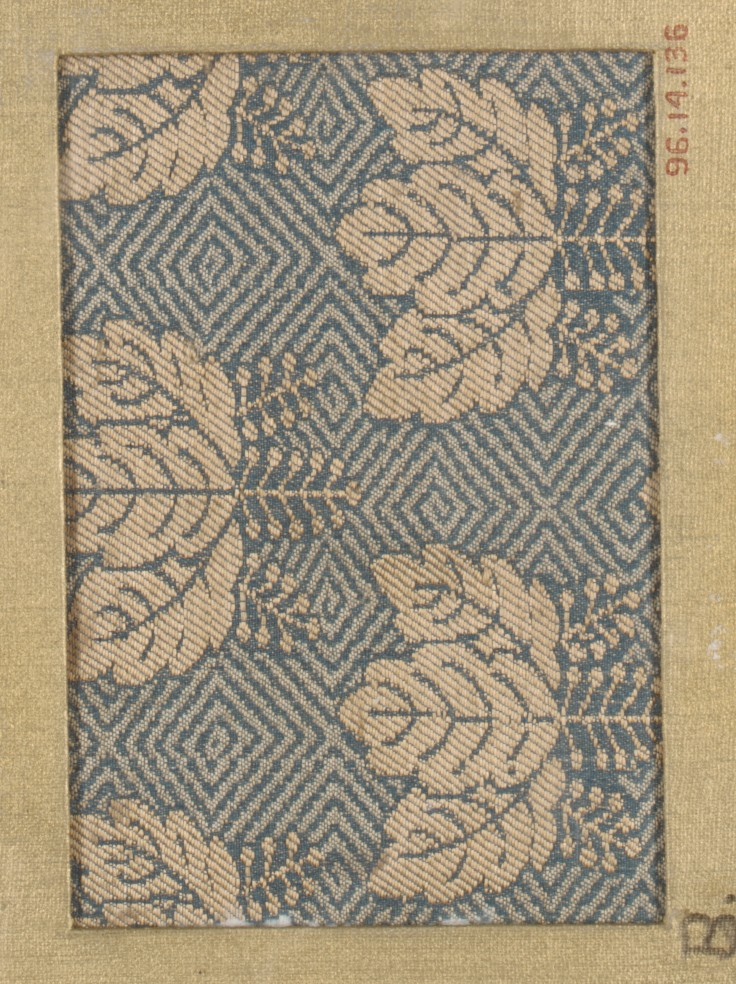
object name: piece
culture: japanese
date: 1701-1900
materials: silk